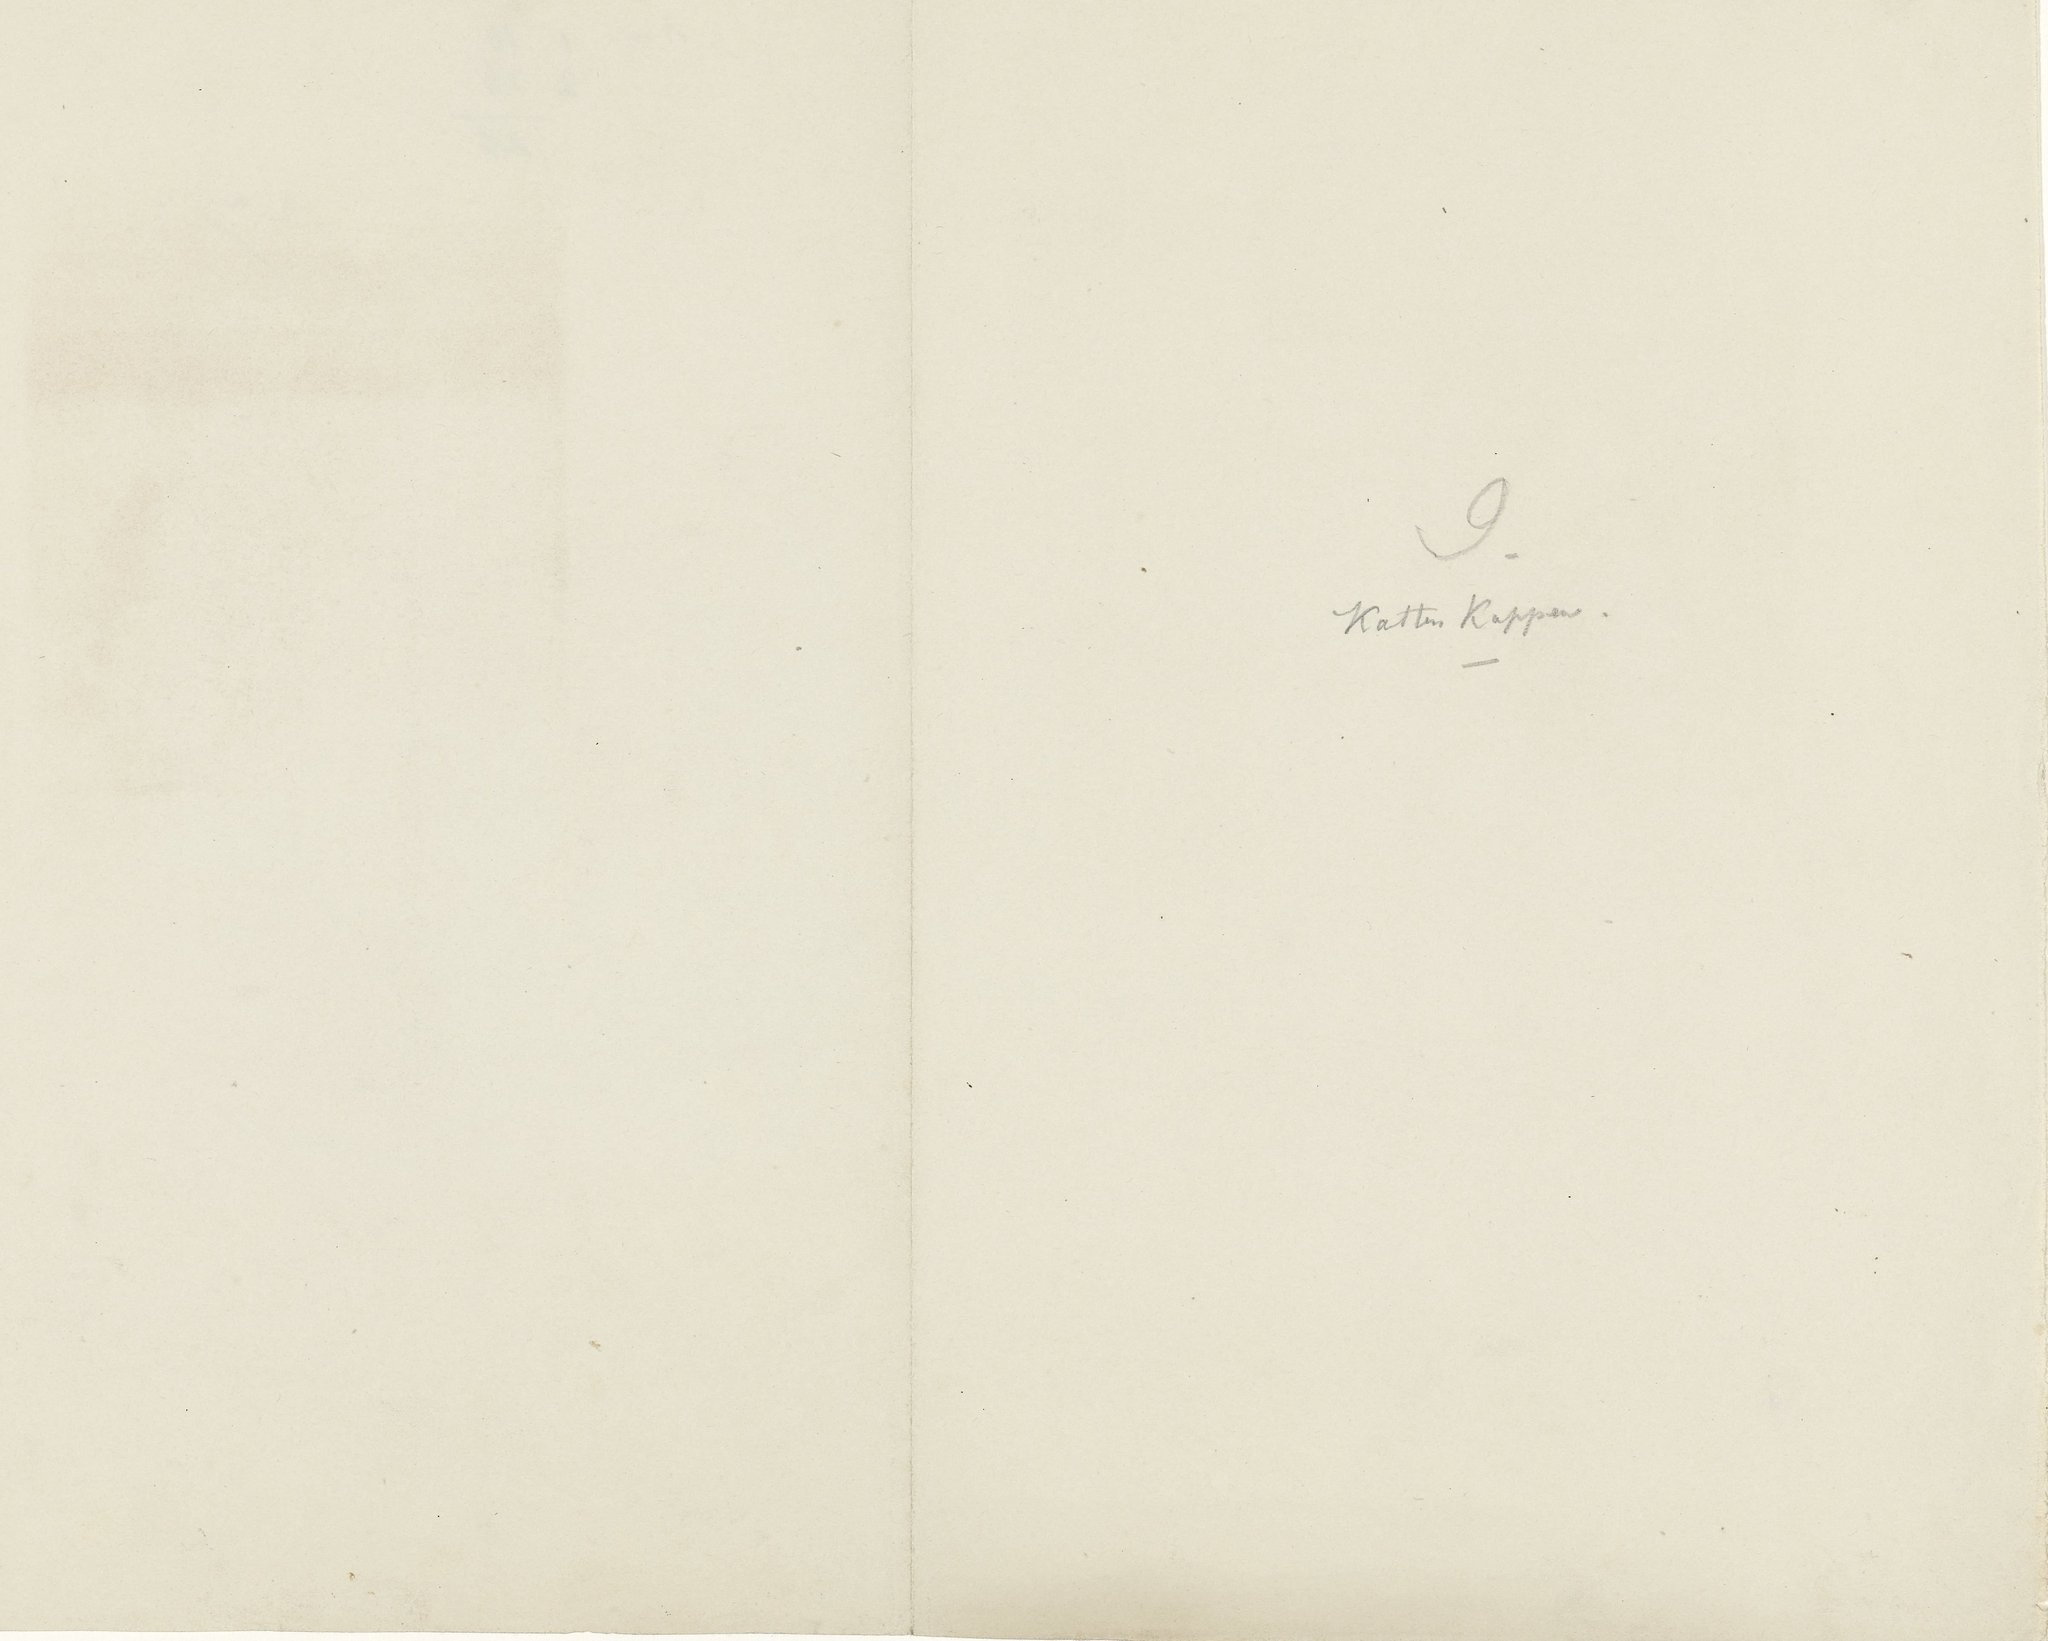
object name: wrapper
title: Omslag voor de verschillende staten van de prent 'Twee katten koppen' door Cornelis van der Grient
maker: cornelis van der griendt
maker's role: draughtsman, painter, print maker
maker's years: 1827-1918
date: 1858-1918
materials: paper, pencil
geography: netherlands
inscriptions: inscription: ‘[...] 26, 2 st’